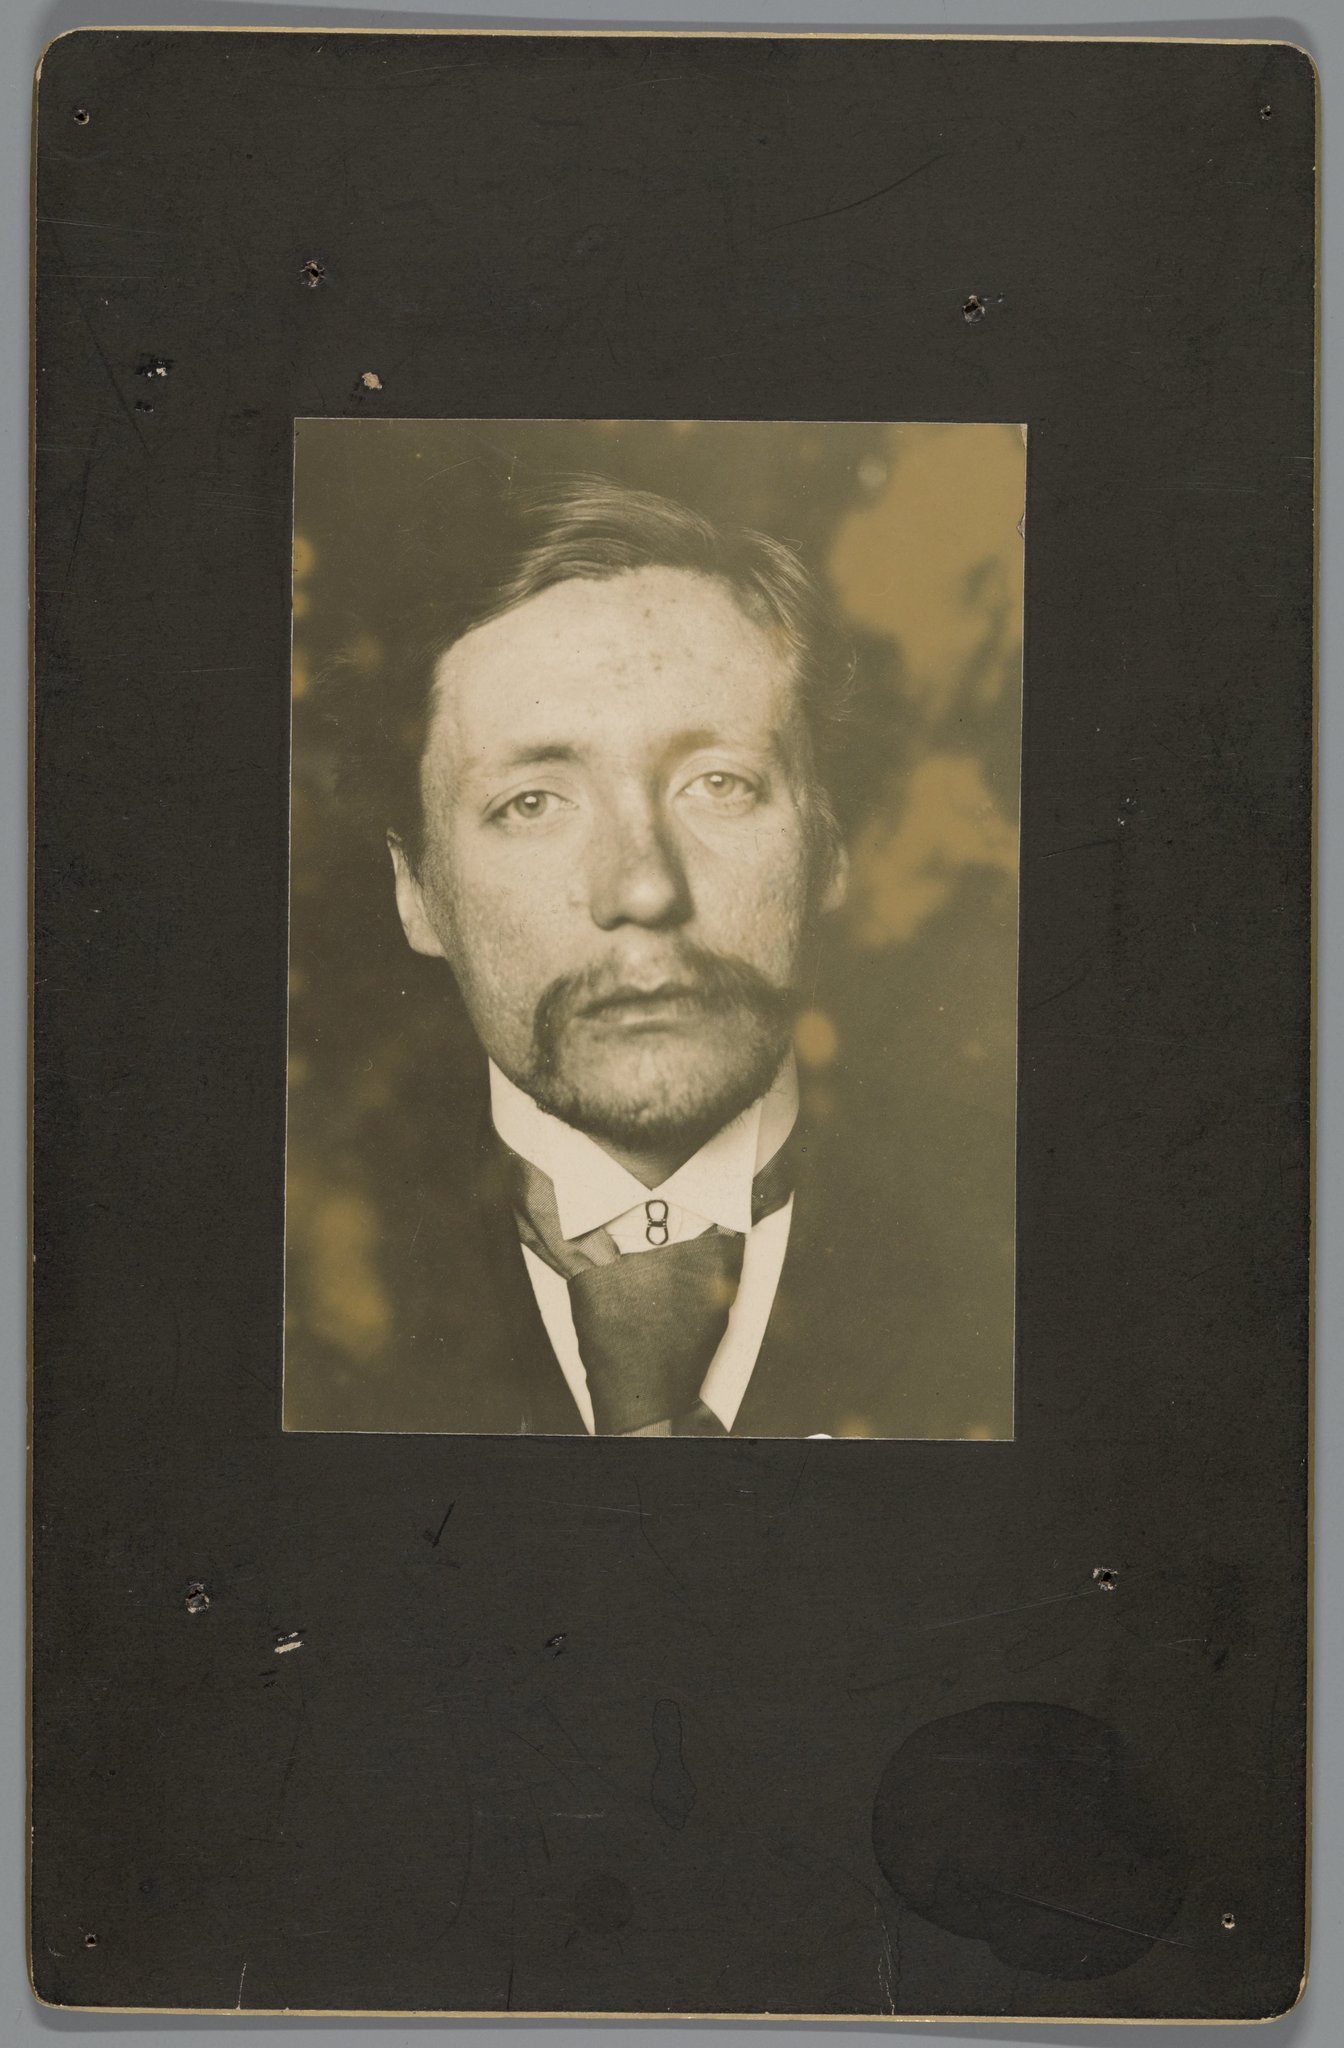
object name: photograph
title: Willem Kloos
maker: Anonymous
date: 1860-1915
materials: cardboard, paper, photographic support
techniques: gelatin silver print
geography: netherlands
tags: amsterdam, the hague, willem kloos